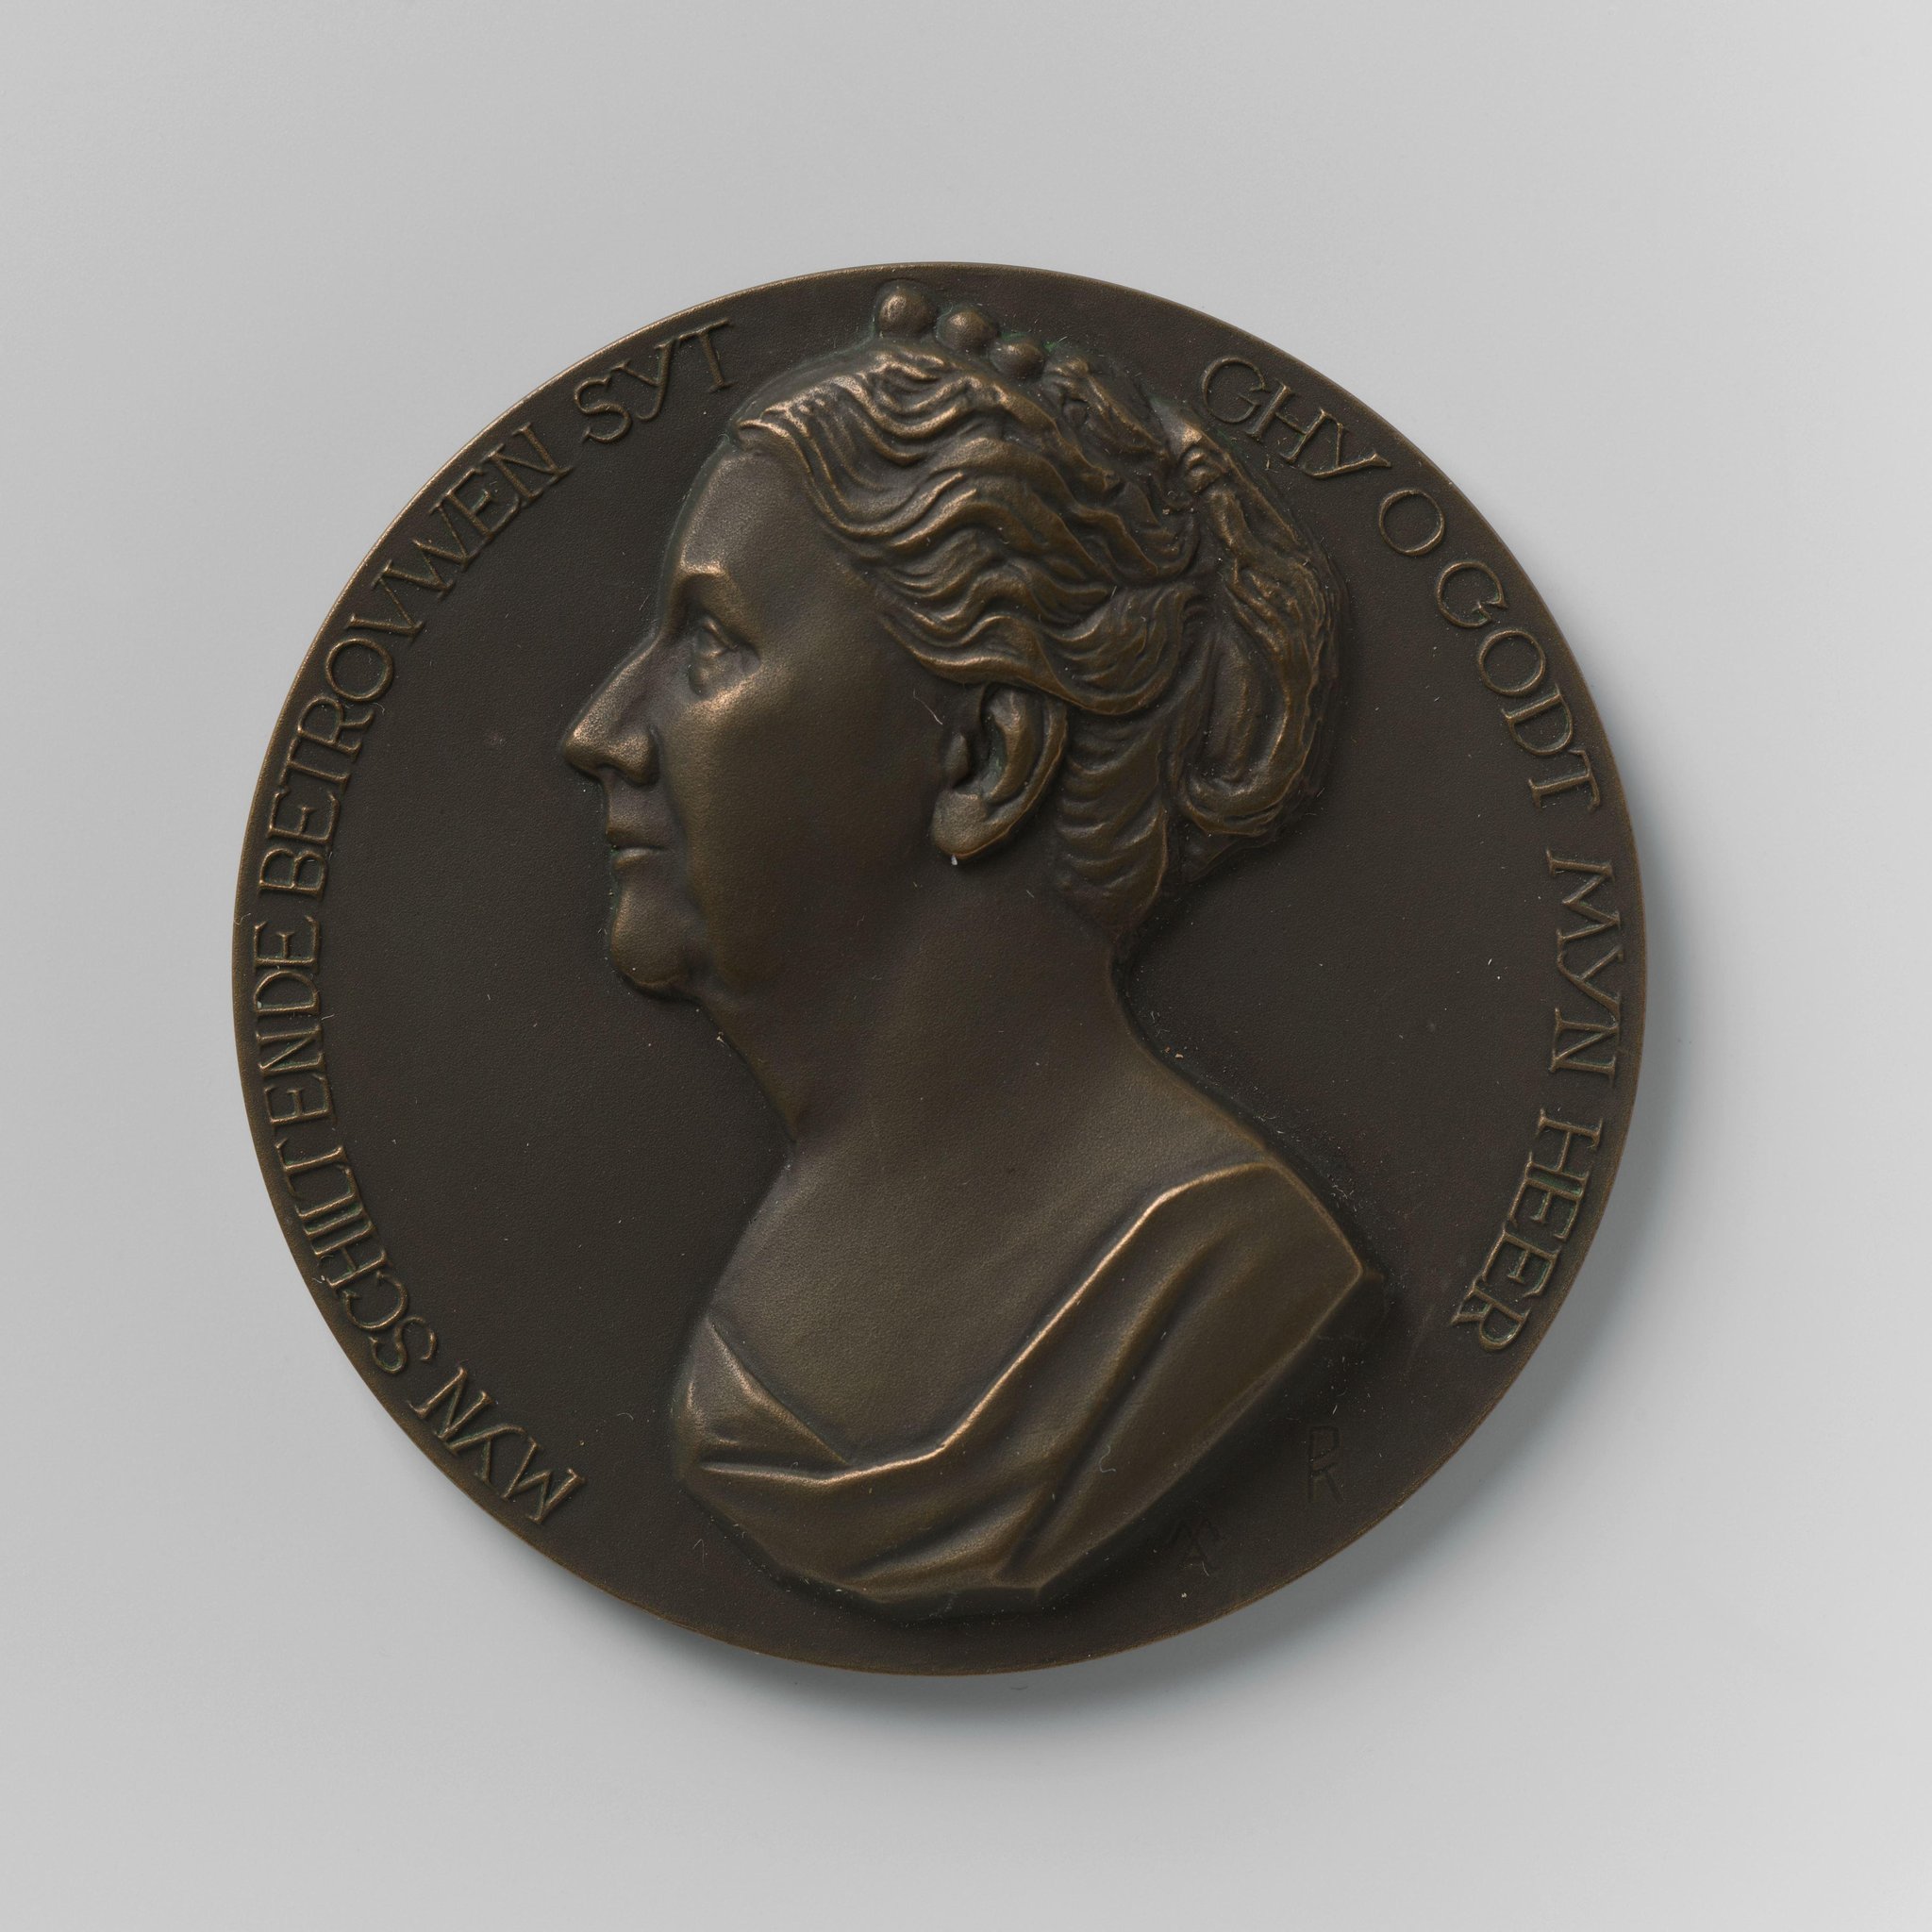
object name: history medal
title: Veertigjarig regeringsjubileum Koningin Wilhelmina (Vereniging voor Penningkunst 1938, eerste penning)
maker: m.s. andriessen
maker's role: sculptor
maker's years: 1897-1979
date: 1938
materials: bronze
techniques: striking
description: Bronzen penning, op de voorzijde het borstbeeld van Wilhelmina naar links met omschrift, op de keerzijde een gekroond zwaard tussen twee jaartallen, met bovenaan omschrift, met verklaring.